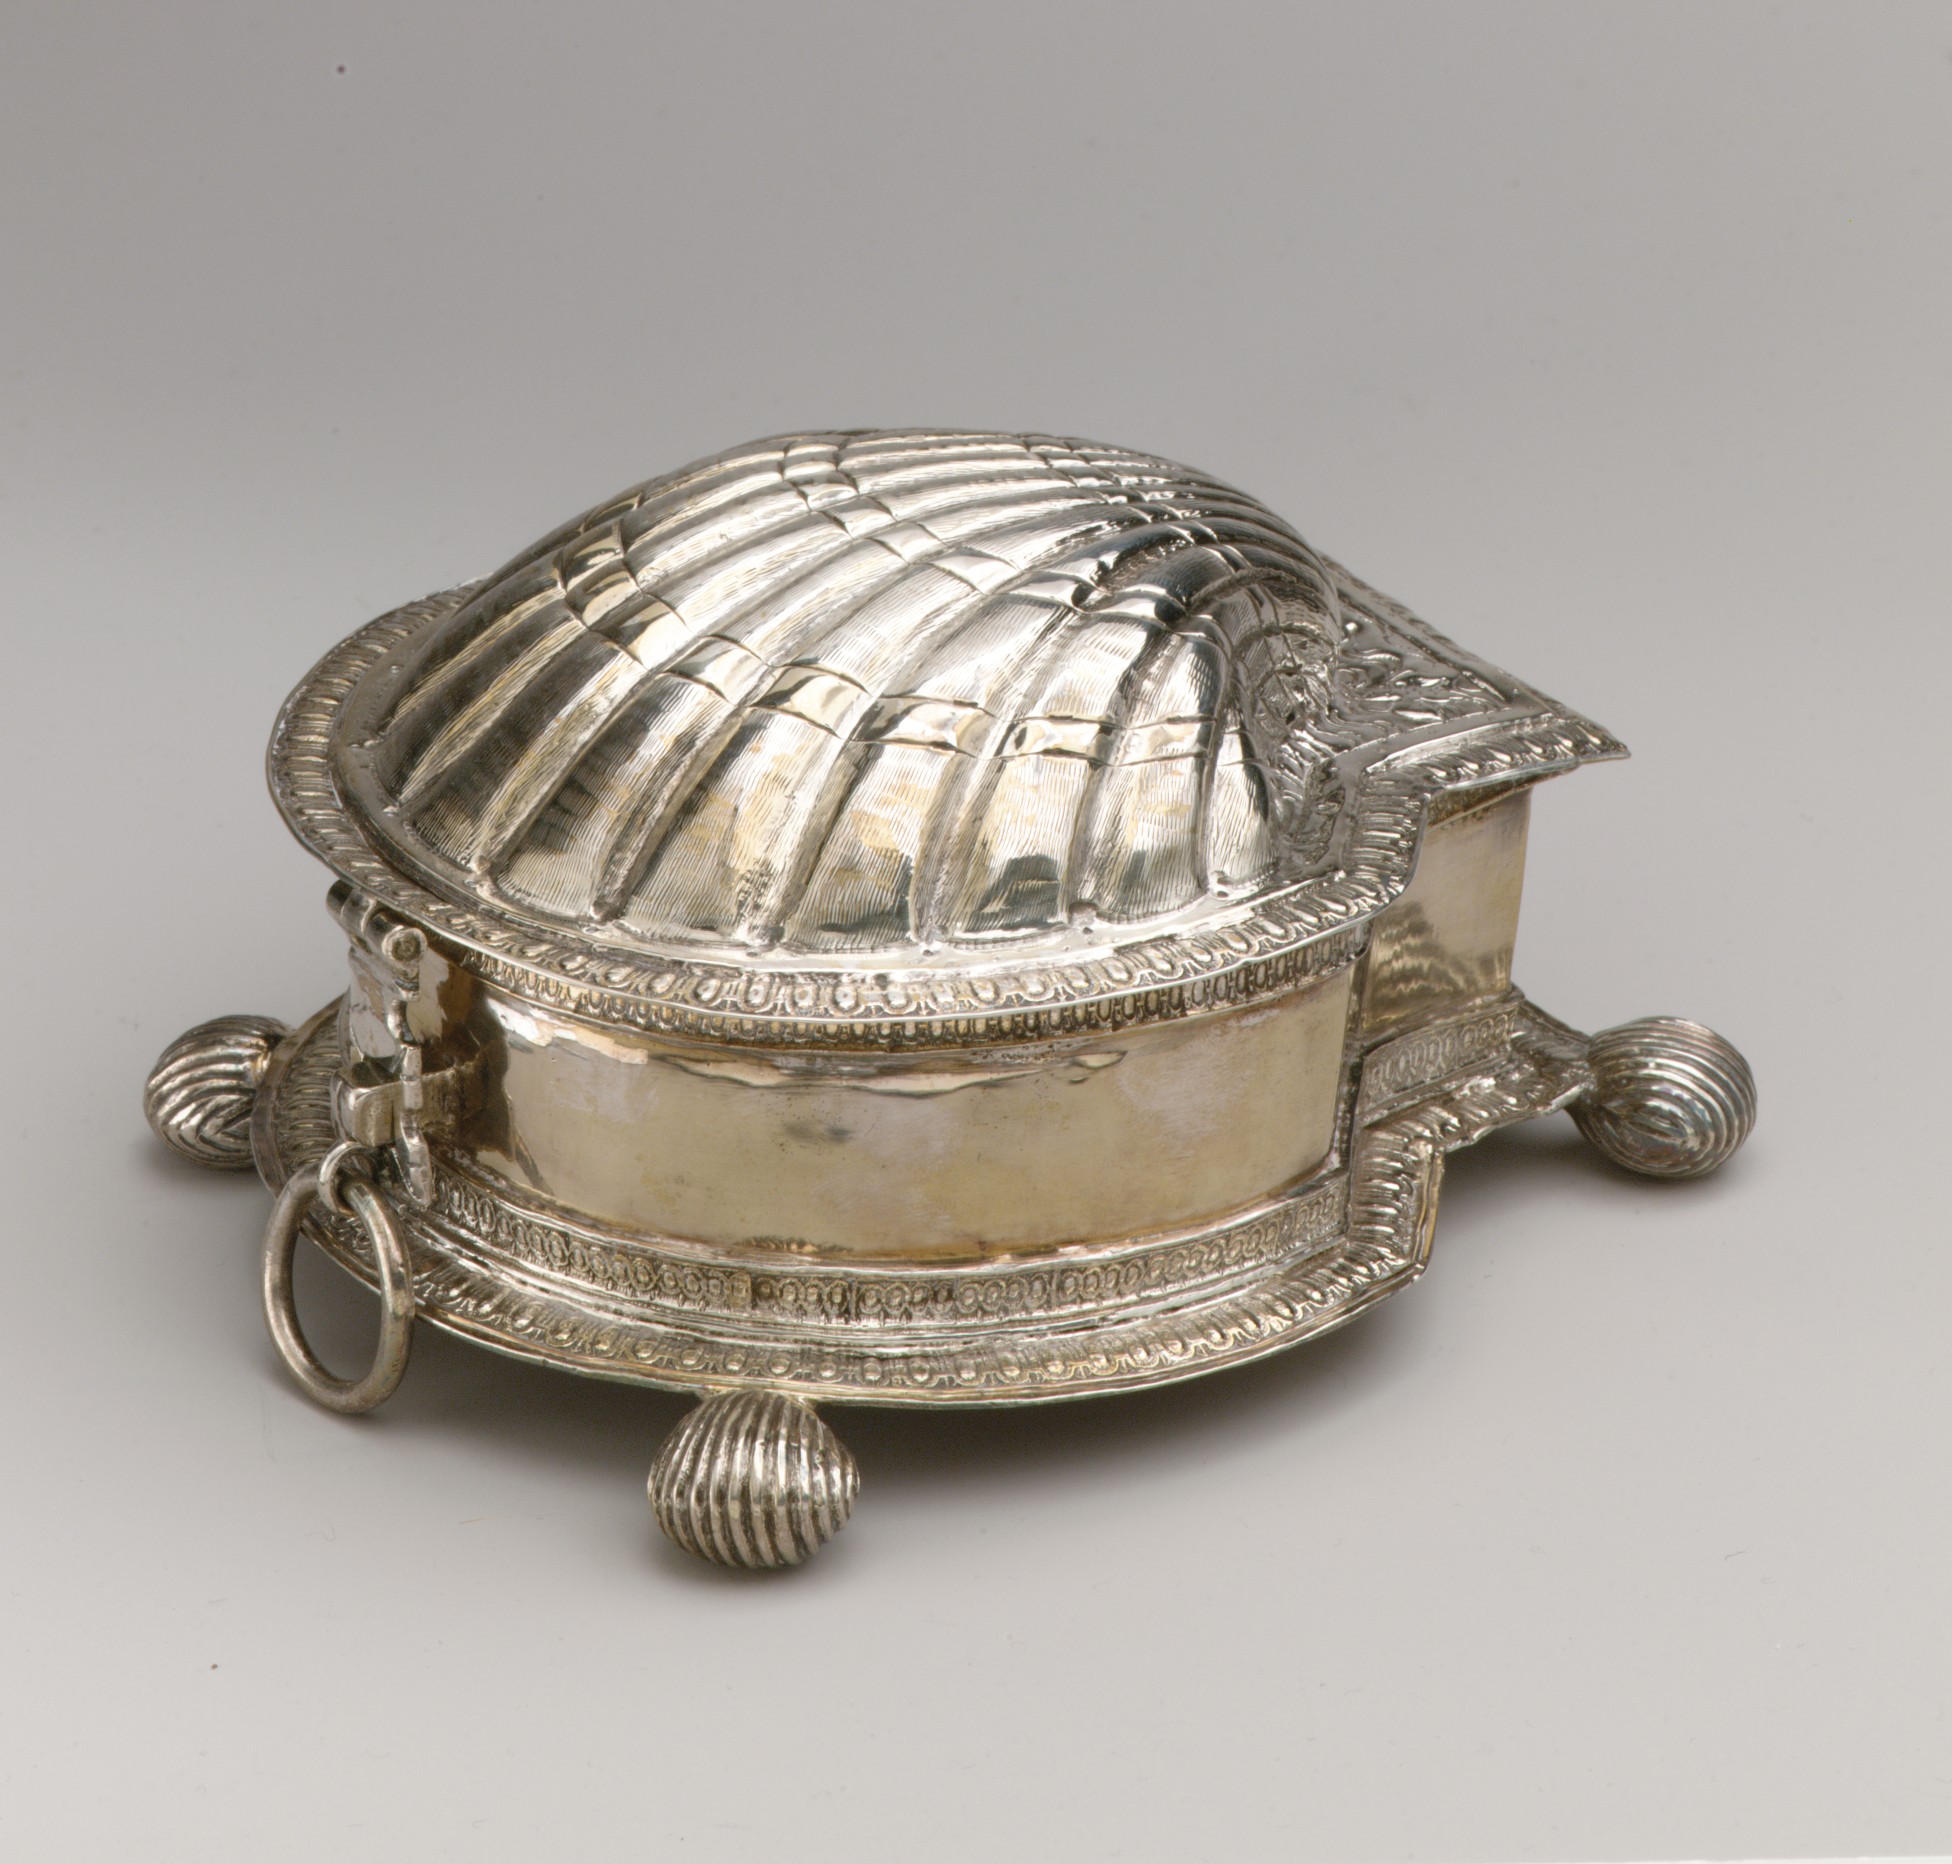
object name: spice box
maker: w. r., london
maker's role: maker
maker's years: 1582-1632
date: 1602-1603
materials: silver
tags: shells